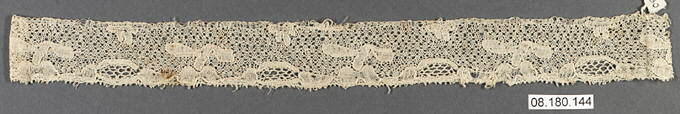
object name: piece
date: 1701-1733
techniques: lace